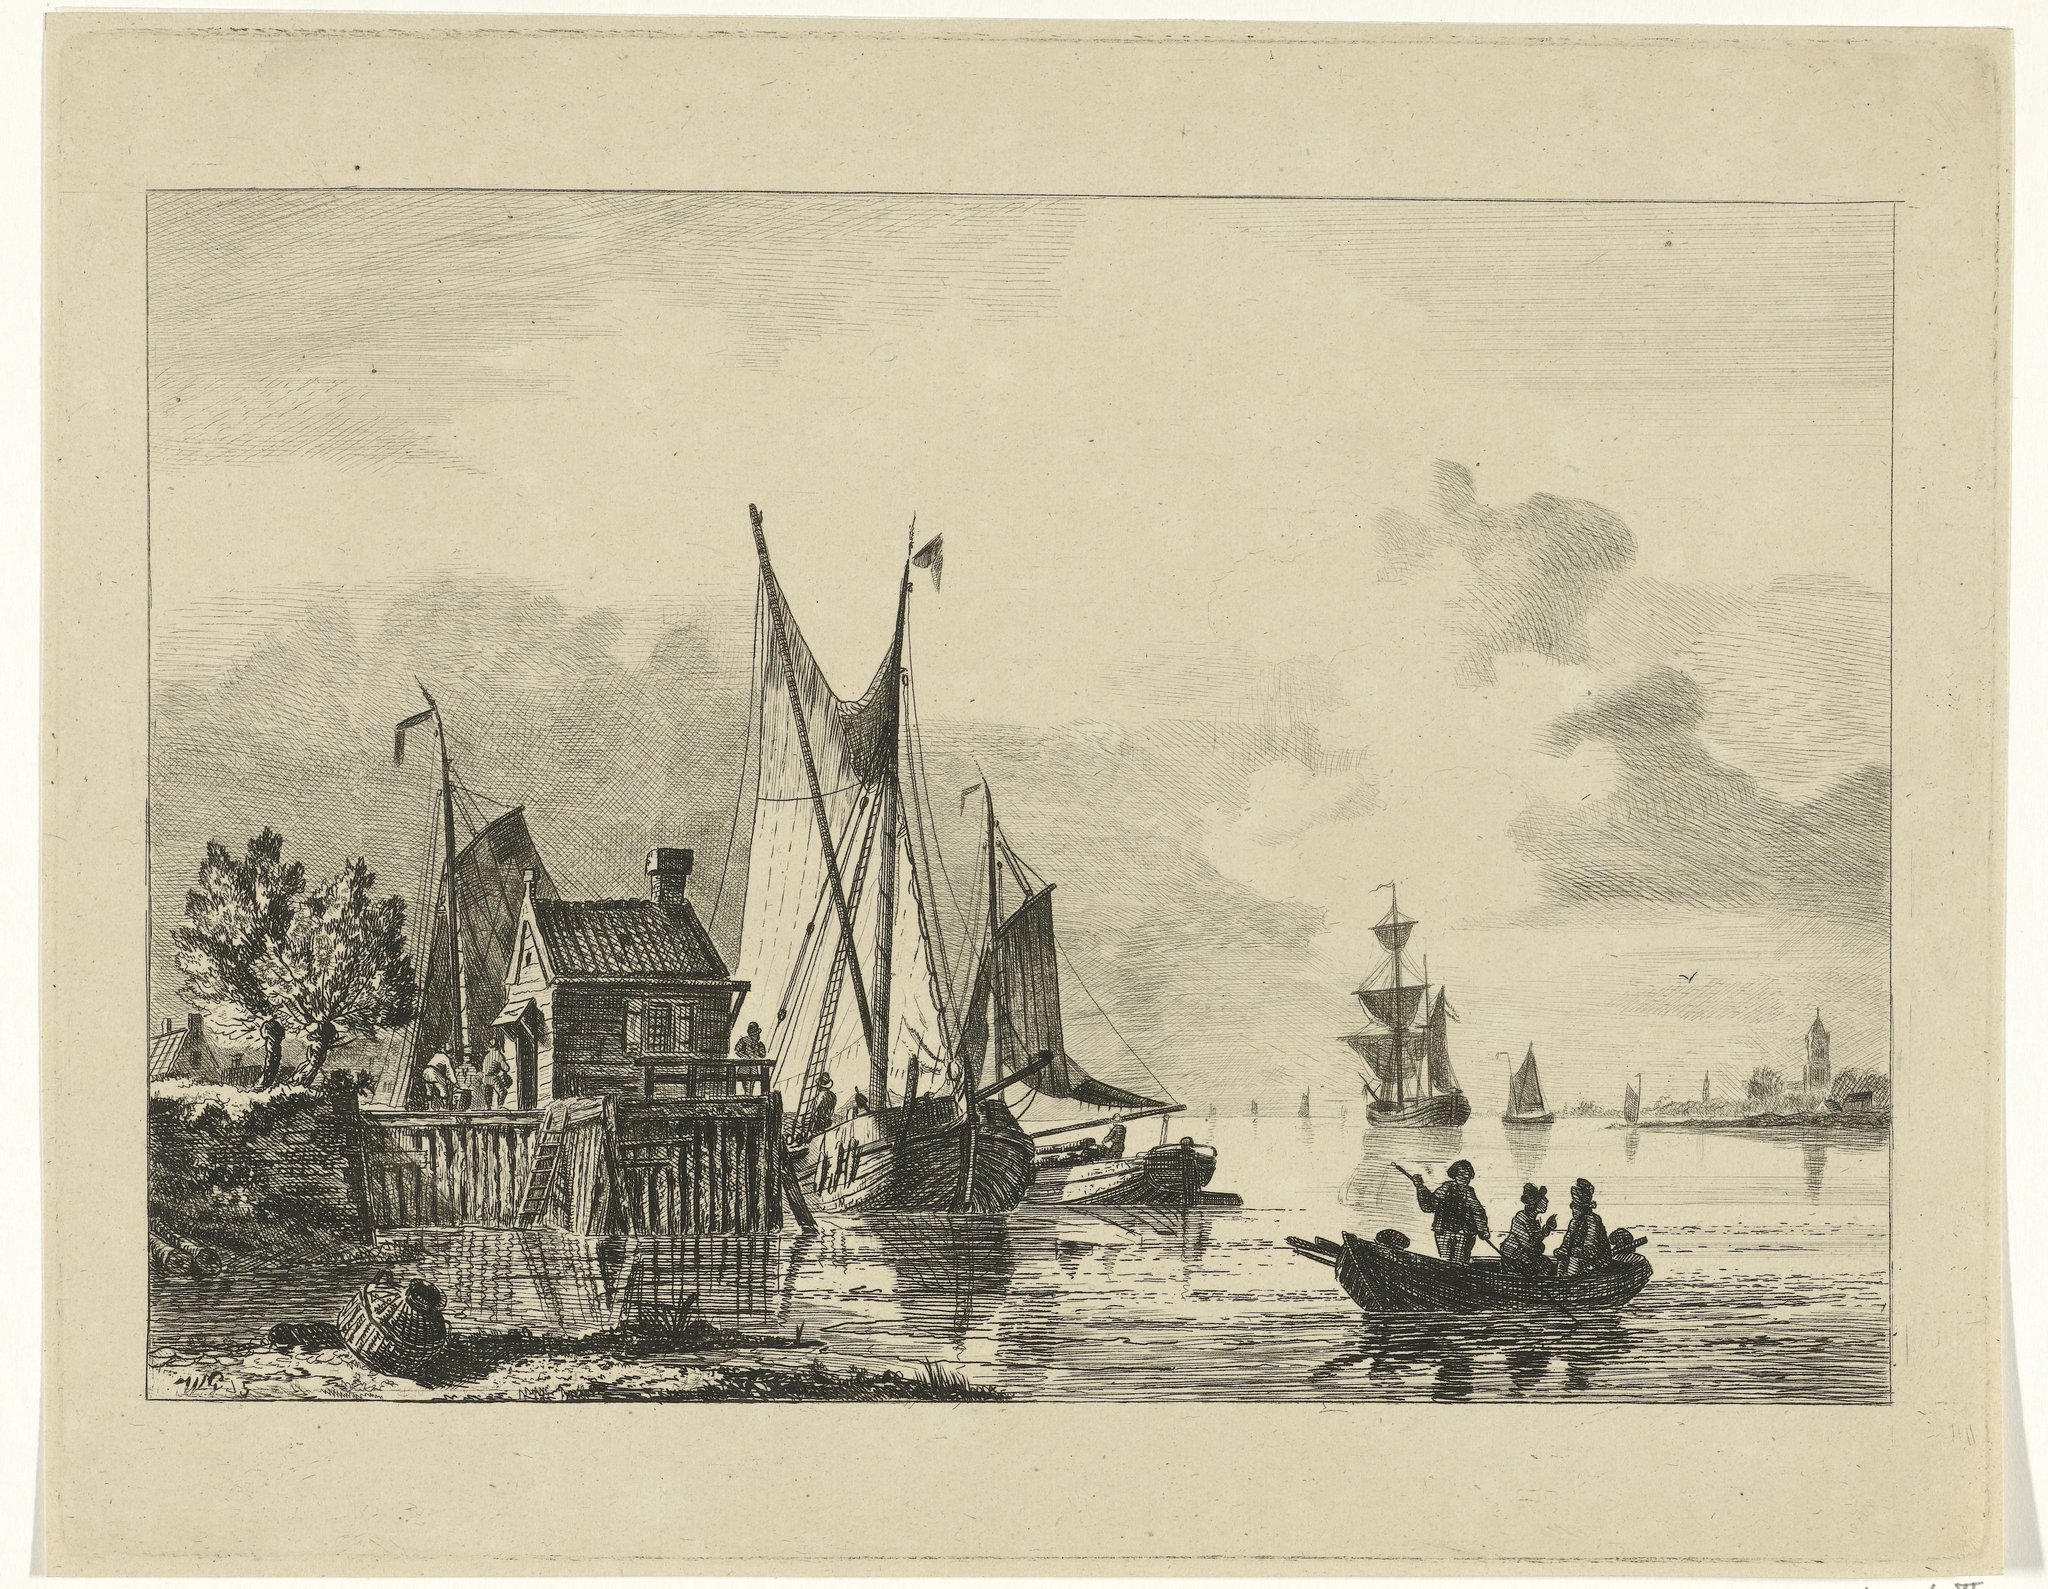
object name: print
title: Riviergezicht met aangemeerde zeilschepen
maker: willem gruyter jr.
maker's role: draughtsman, print maker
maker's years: 1817-1880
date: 1832-1880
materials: paper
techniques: etching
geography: amsterdam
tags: rowing-boat, canoe, etc., sailing-ship, sailing-boat (+ four persons or more ~ traffic and transport)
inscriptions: collector's mark: Lugt 2165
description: Houten huis bij een pier met aangemeerde zeilschepen en rechts op de voorgrond een roeiboot met drie mannen erin.